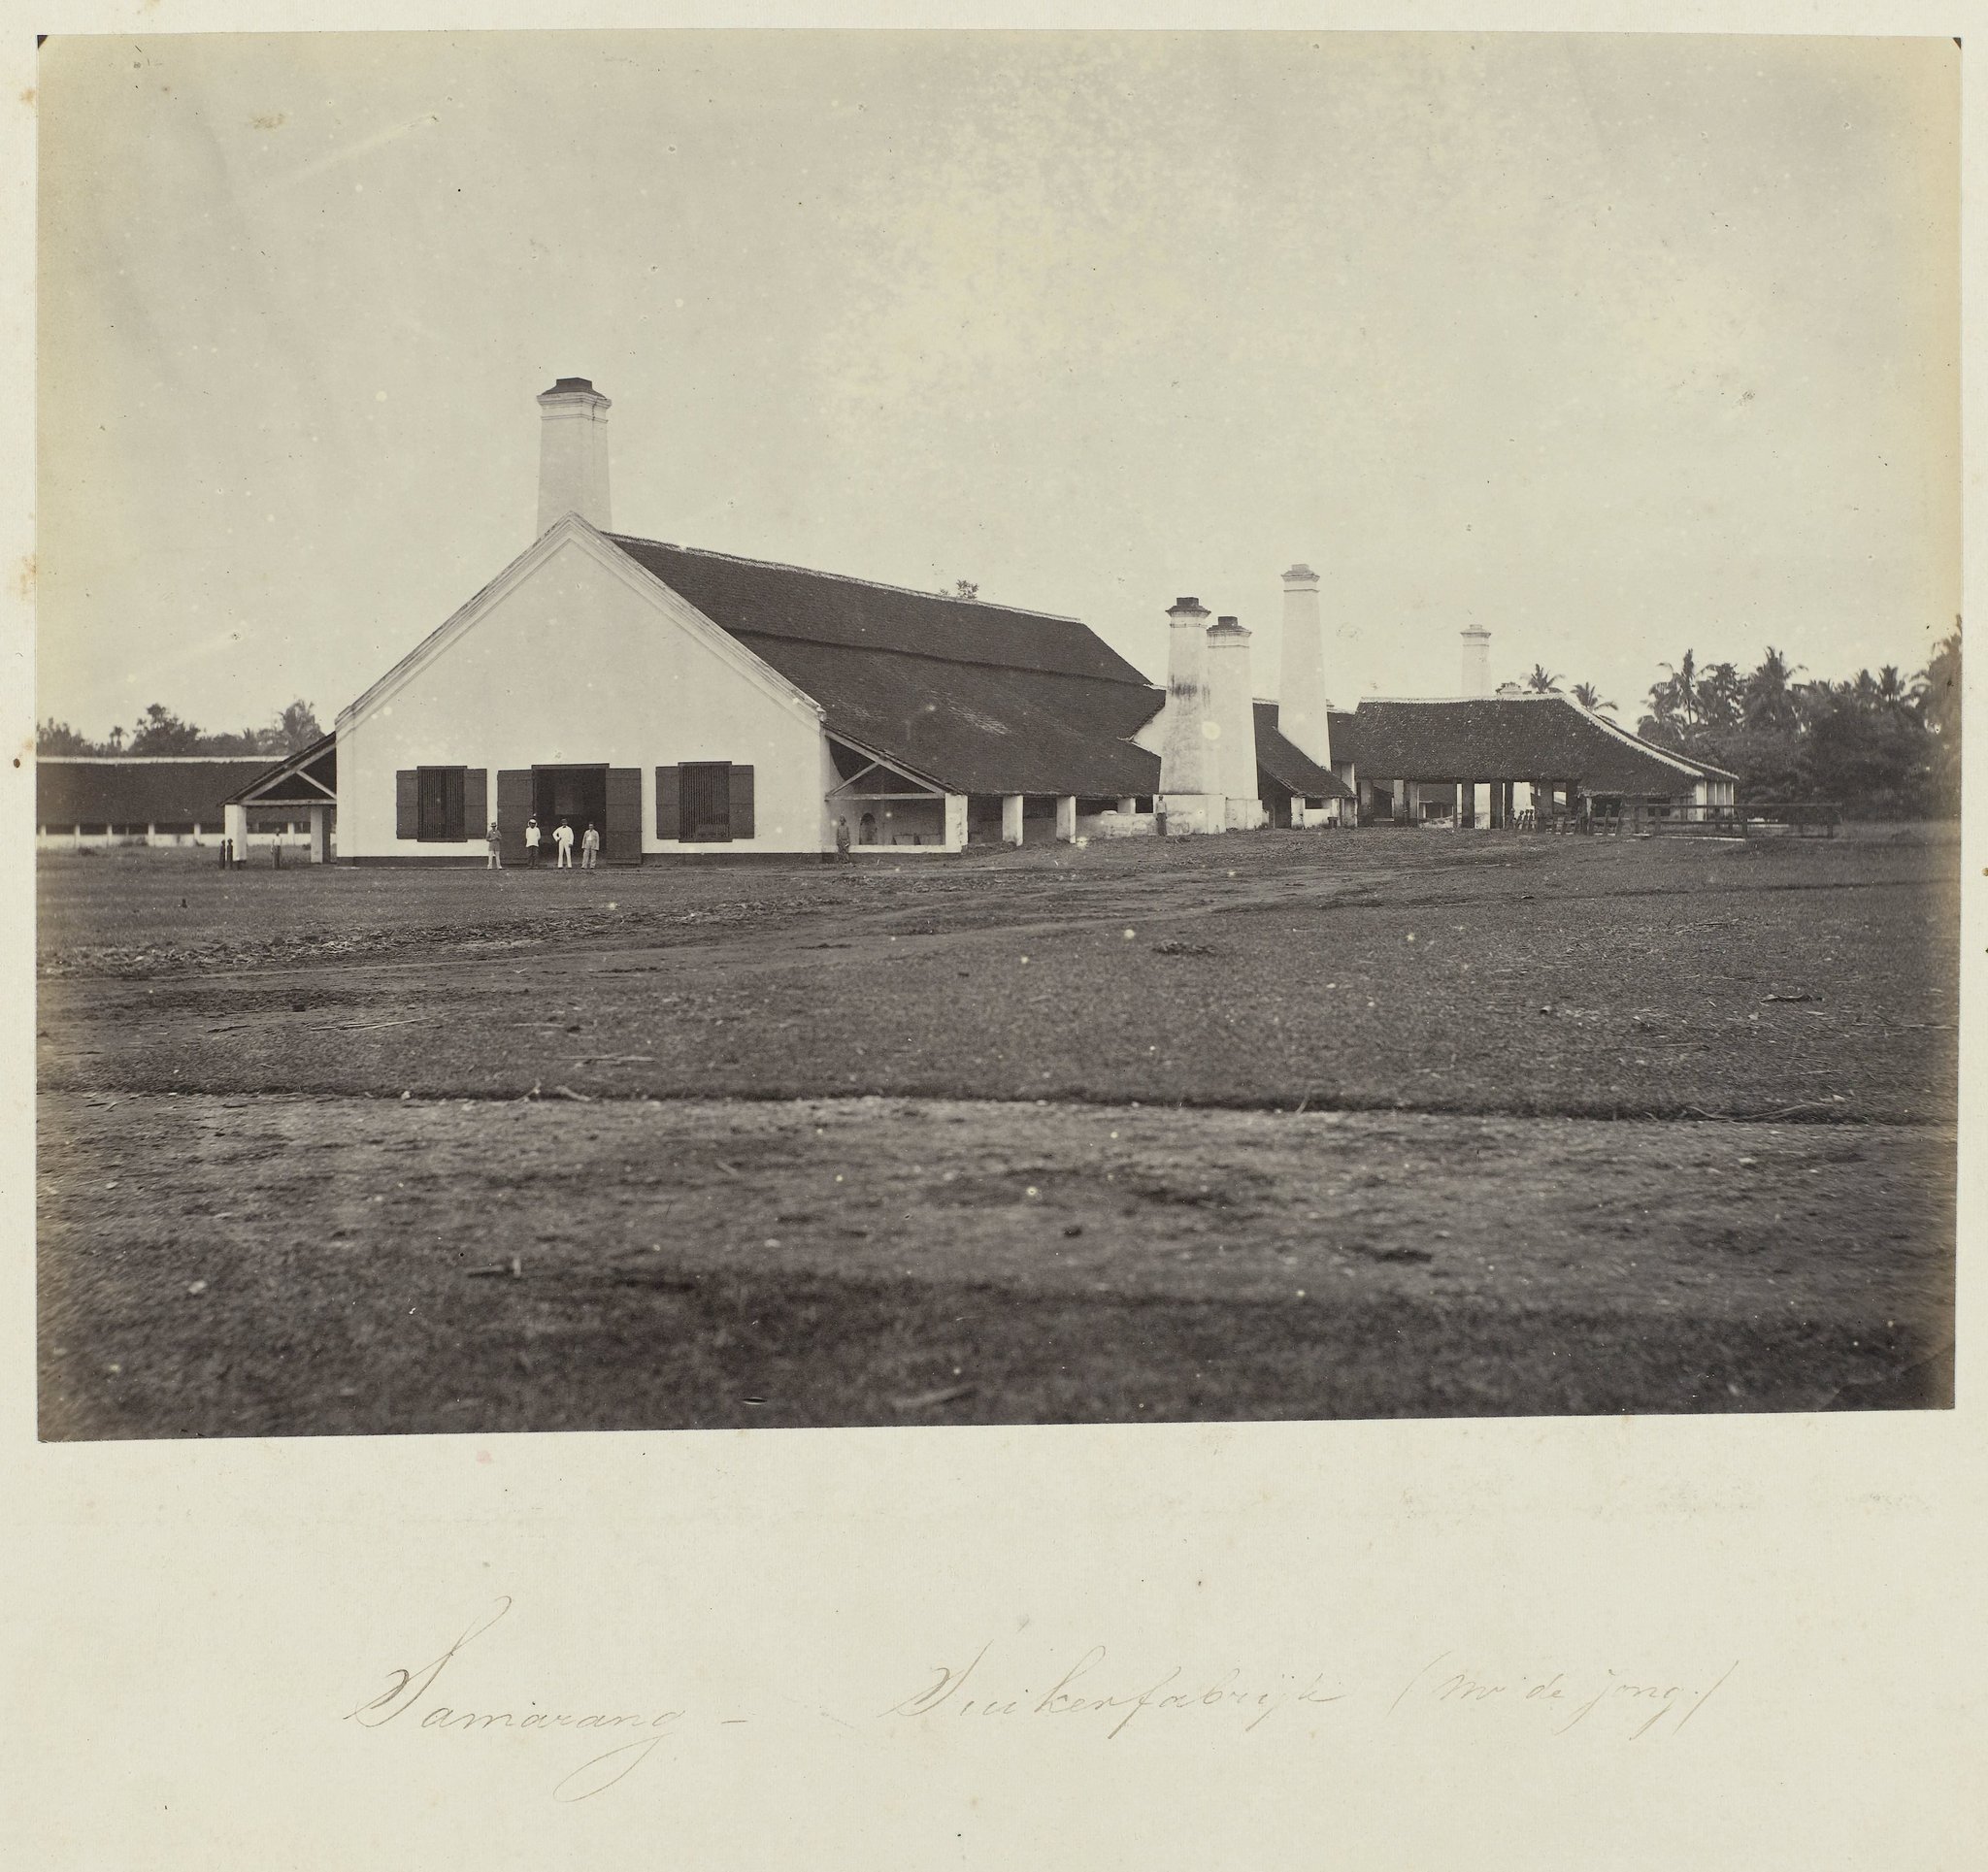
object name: photograph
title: Samarang - Suikerfabrijk (mr de Jong)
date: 1863-1869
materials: photographic support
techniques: albumen print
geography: semarang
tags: factory-building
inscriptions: inscription: ‘Samarang - Suikerfabrijk (mr de Jong)’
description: Gebouwen van de suikerfabriek van mr. de Jong, te Samarang. Onderdeel van het groene fotoalbum met foto's van Java, uit het bezit van apotheker Specht-Grijp, die in 1865 vanuit Batavia naar Nederland terugkeerde.